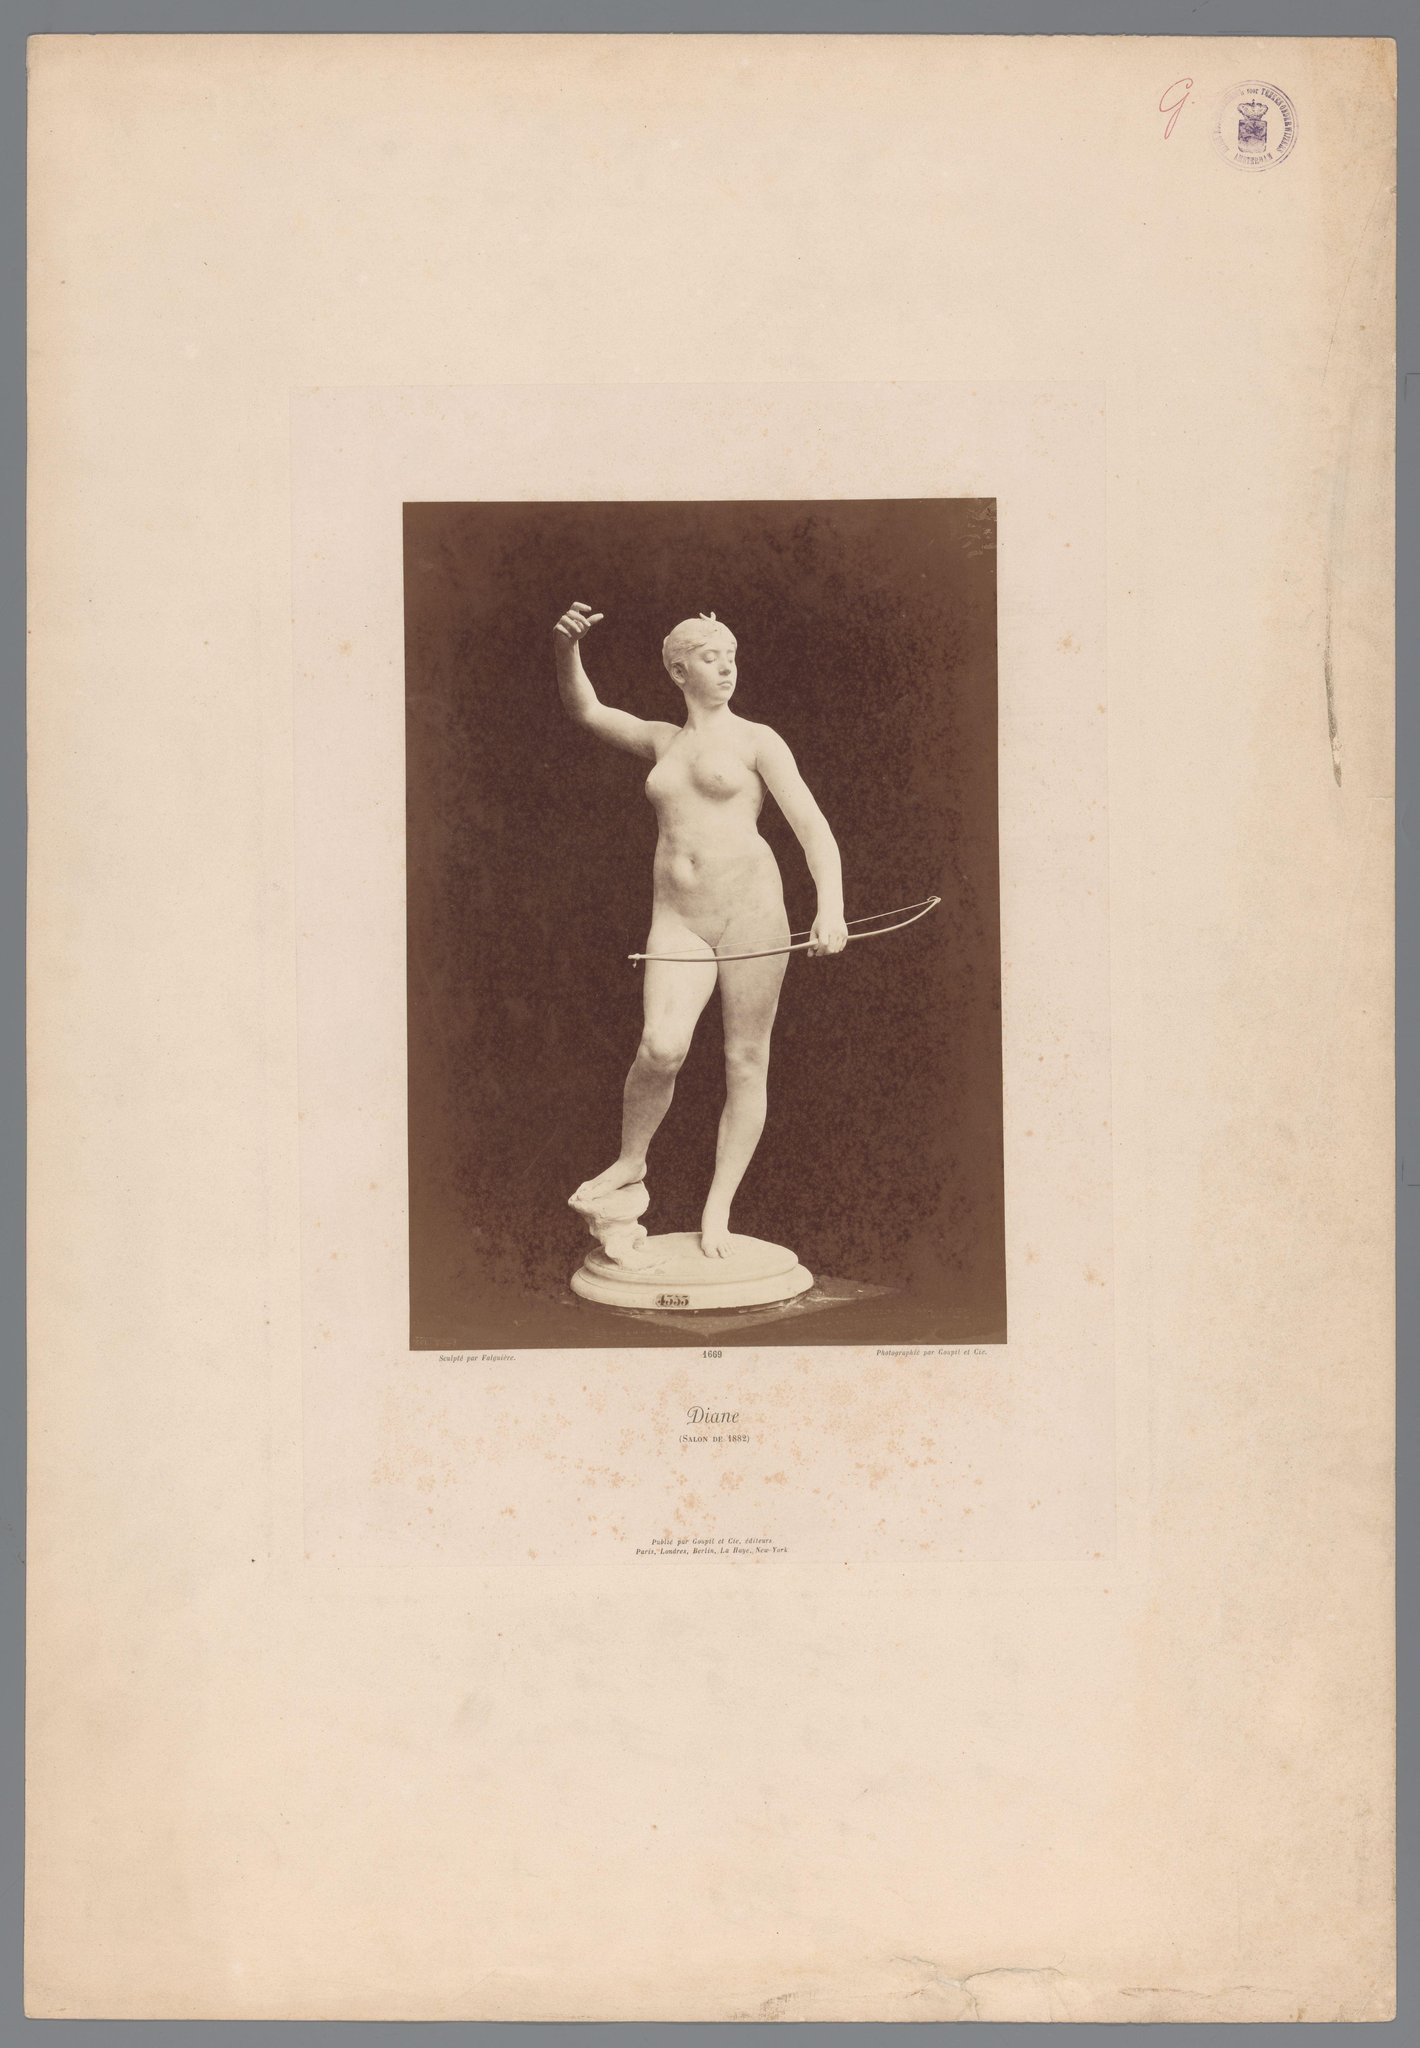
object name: photograph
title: Diane (Salon de 1882)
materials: cardboard, paper, photographic support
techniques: albumen print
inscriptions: : ‘G’, stamp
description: Sculptuur door Falguière van de godin Diana met boog.